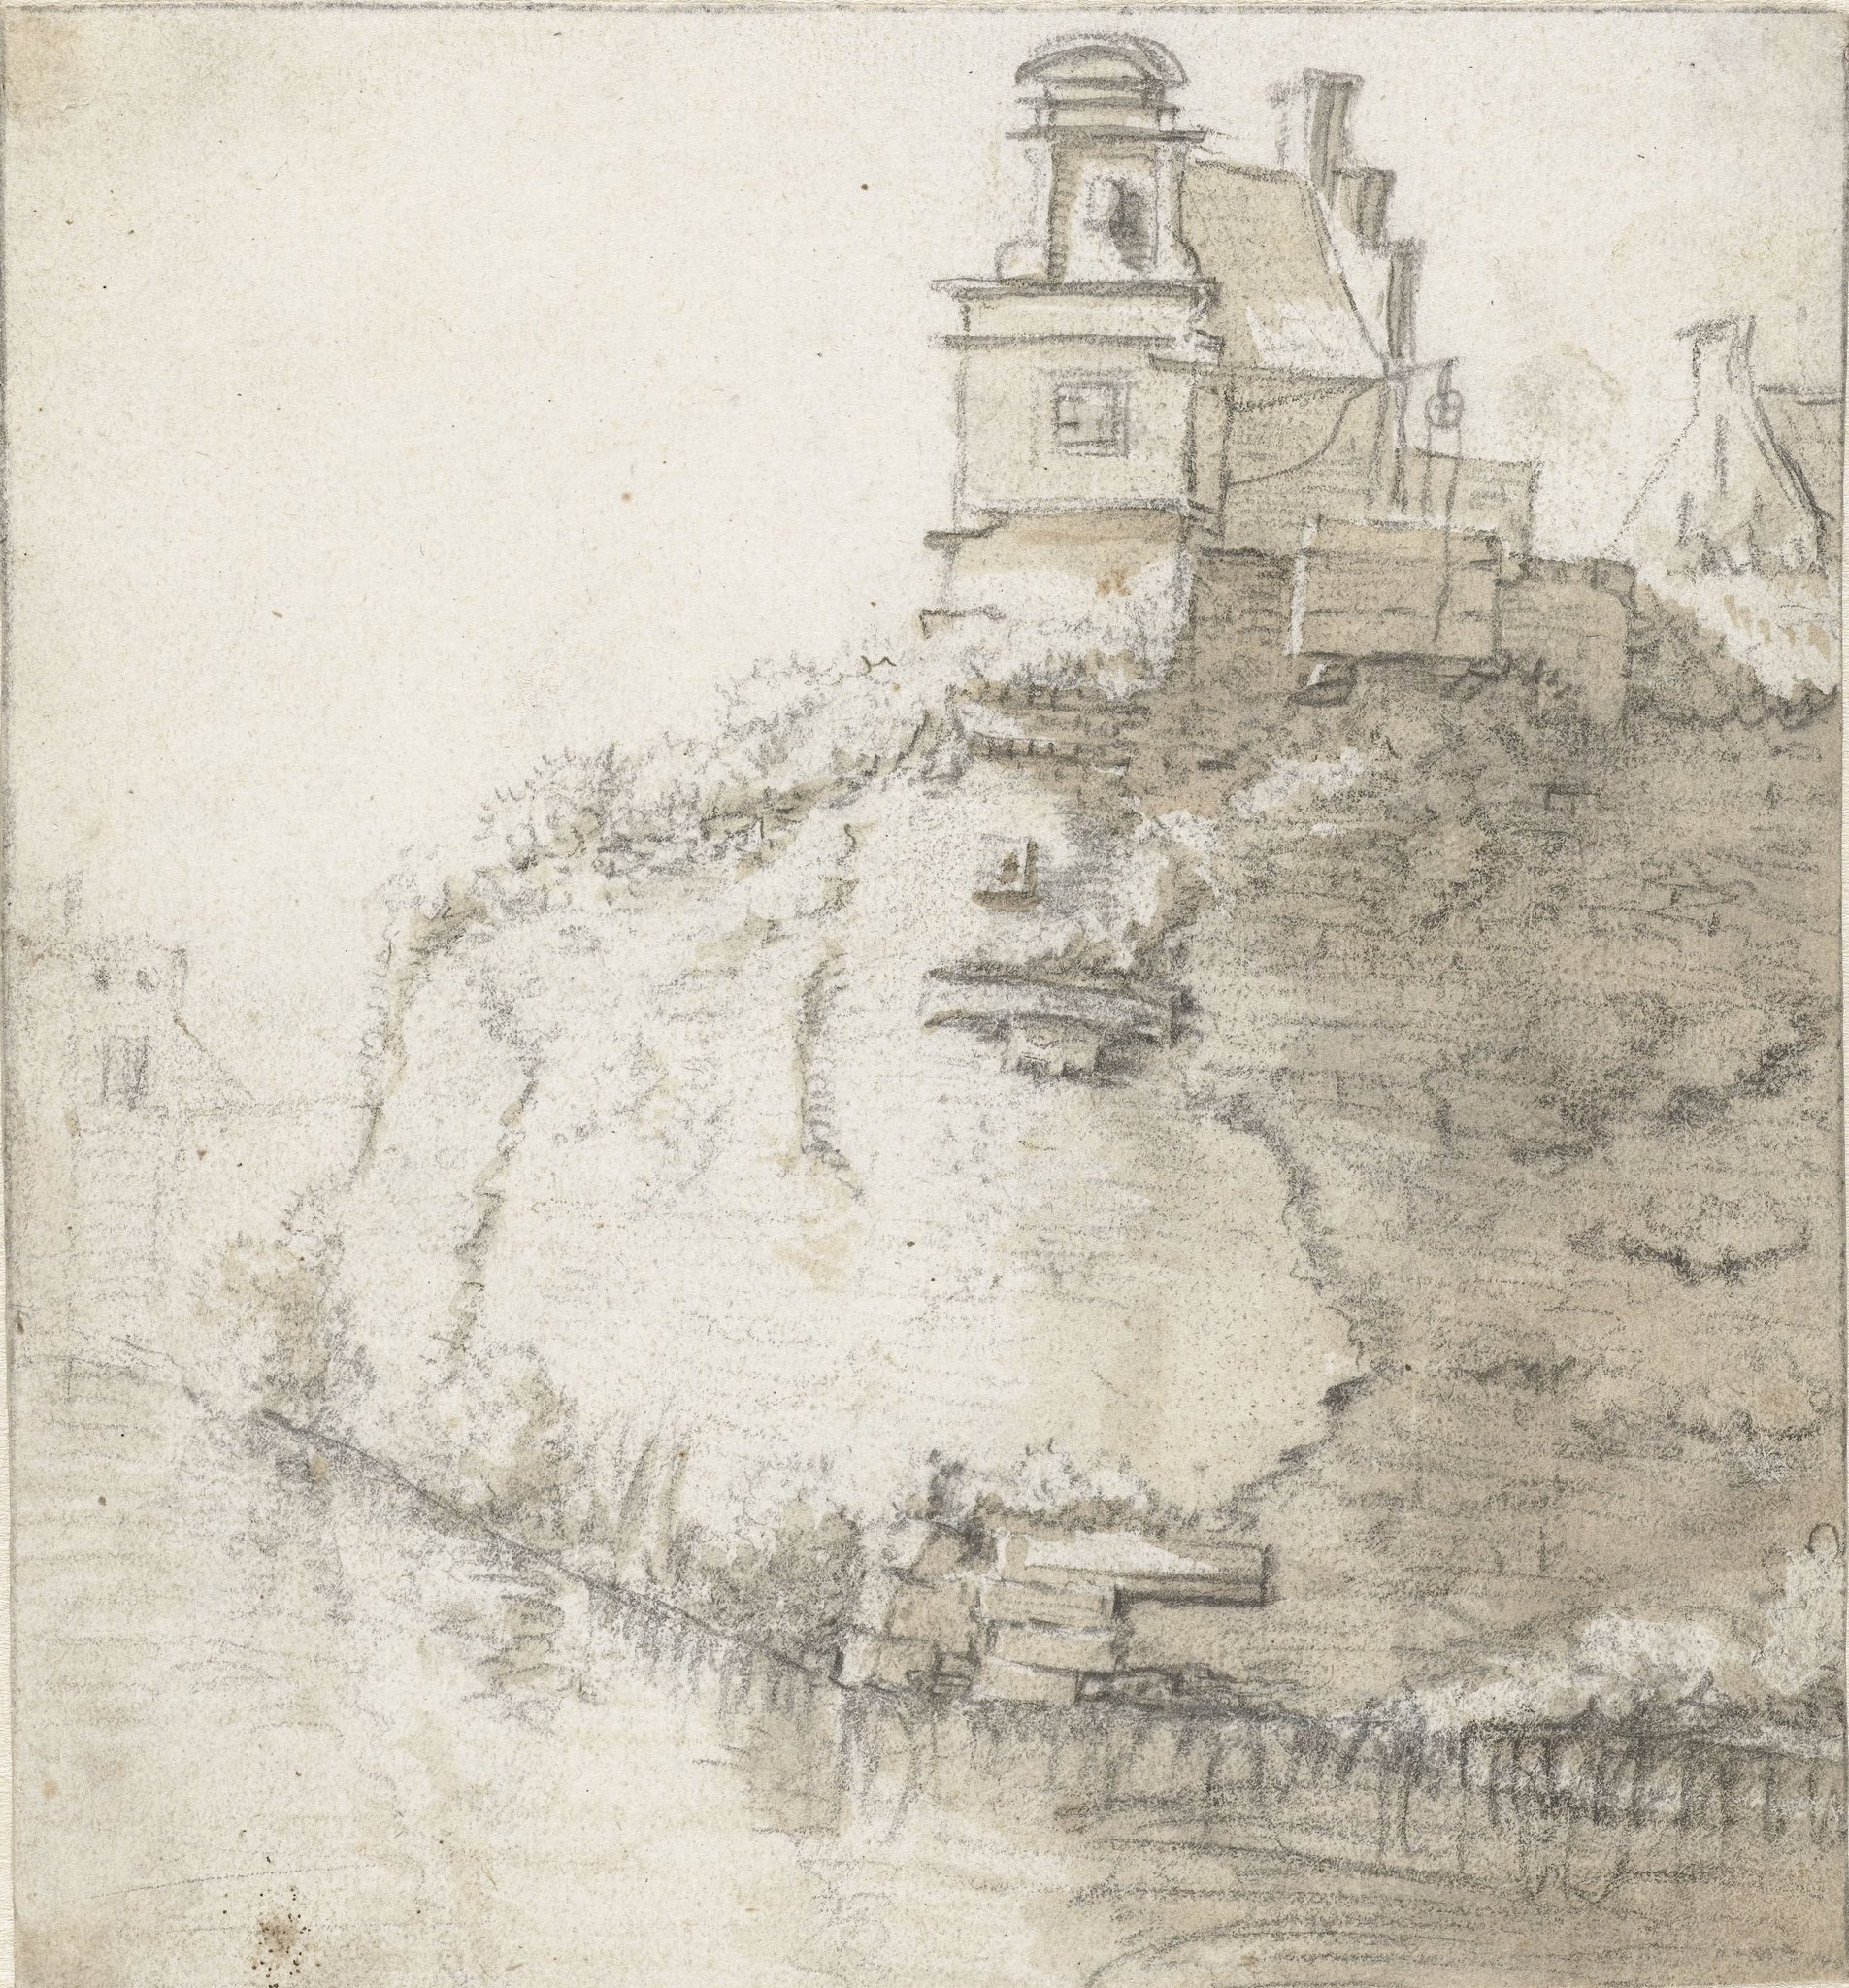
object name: drawing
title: Het bolwerk Zonneburg te Utrecht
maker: herman saftleven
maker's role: draughtsman, painter, print maker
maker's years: 1609-1685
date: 1619-1685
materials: chalk, paper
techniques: brush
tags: ruin of a building ~ architecture, bastion, bulwark, utrecht